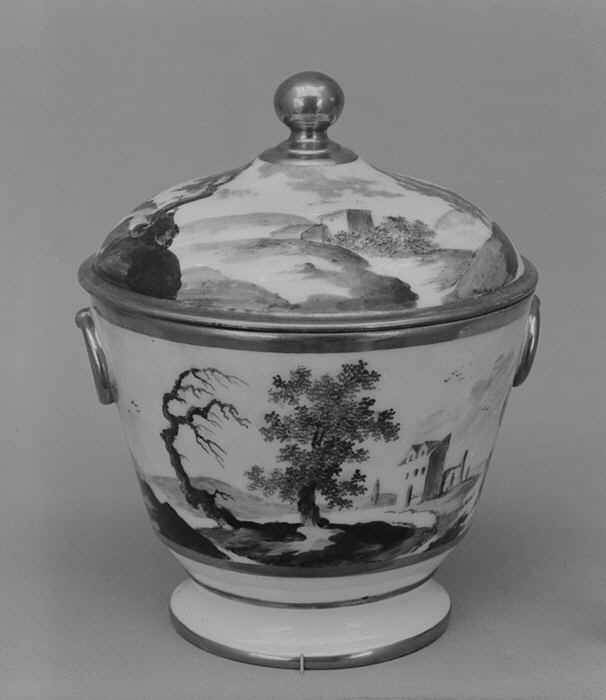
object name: sugar bowl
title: Sugar bowl (part of a tea set)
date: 1805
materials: hard paste porcelain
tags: buildings,landscapes,trees